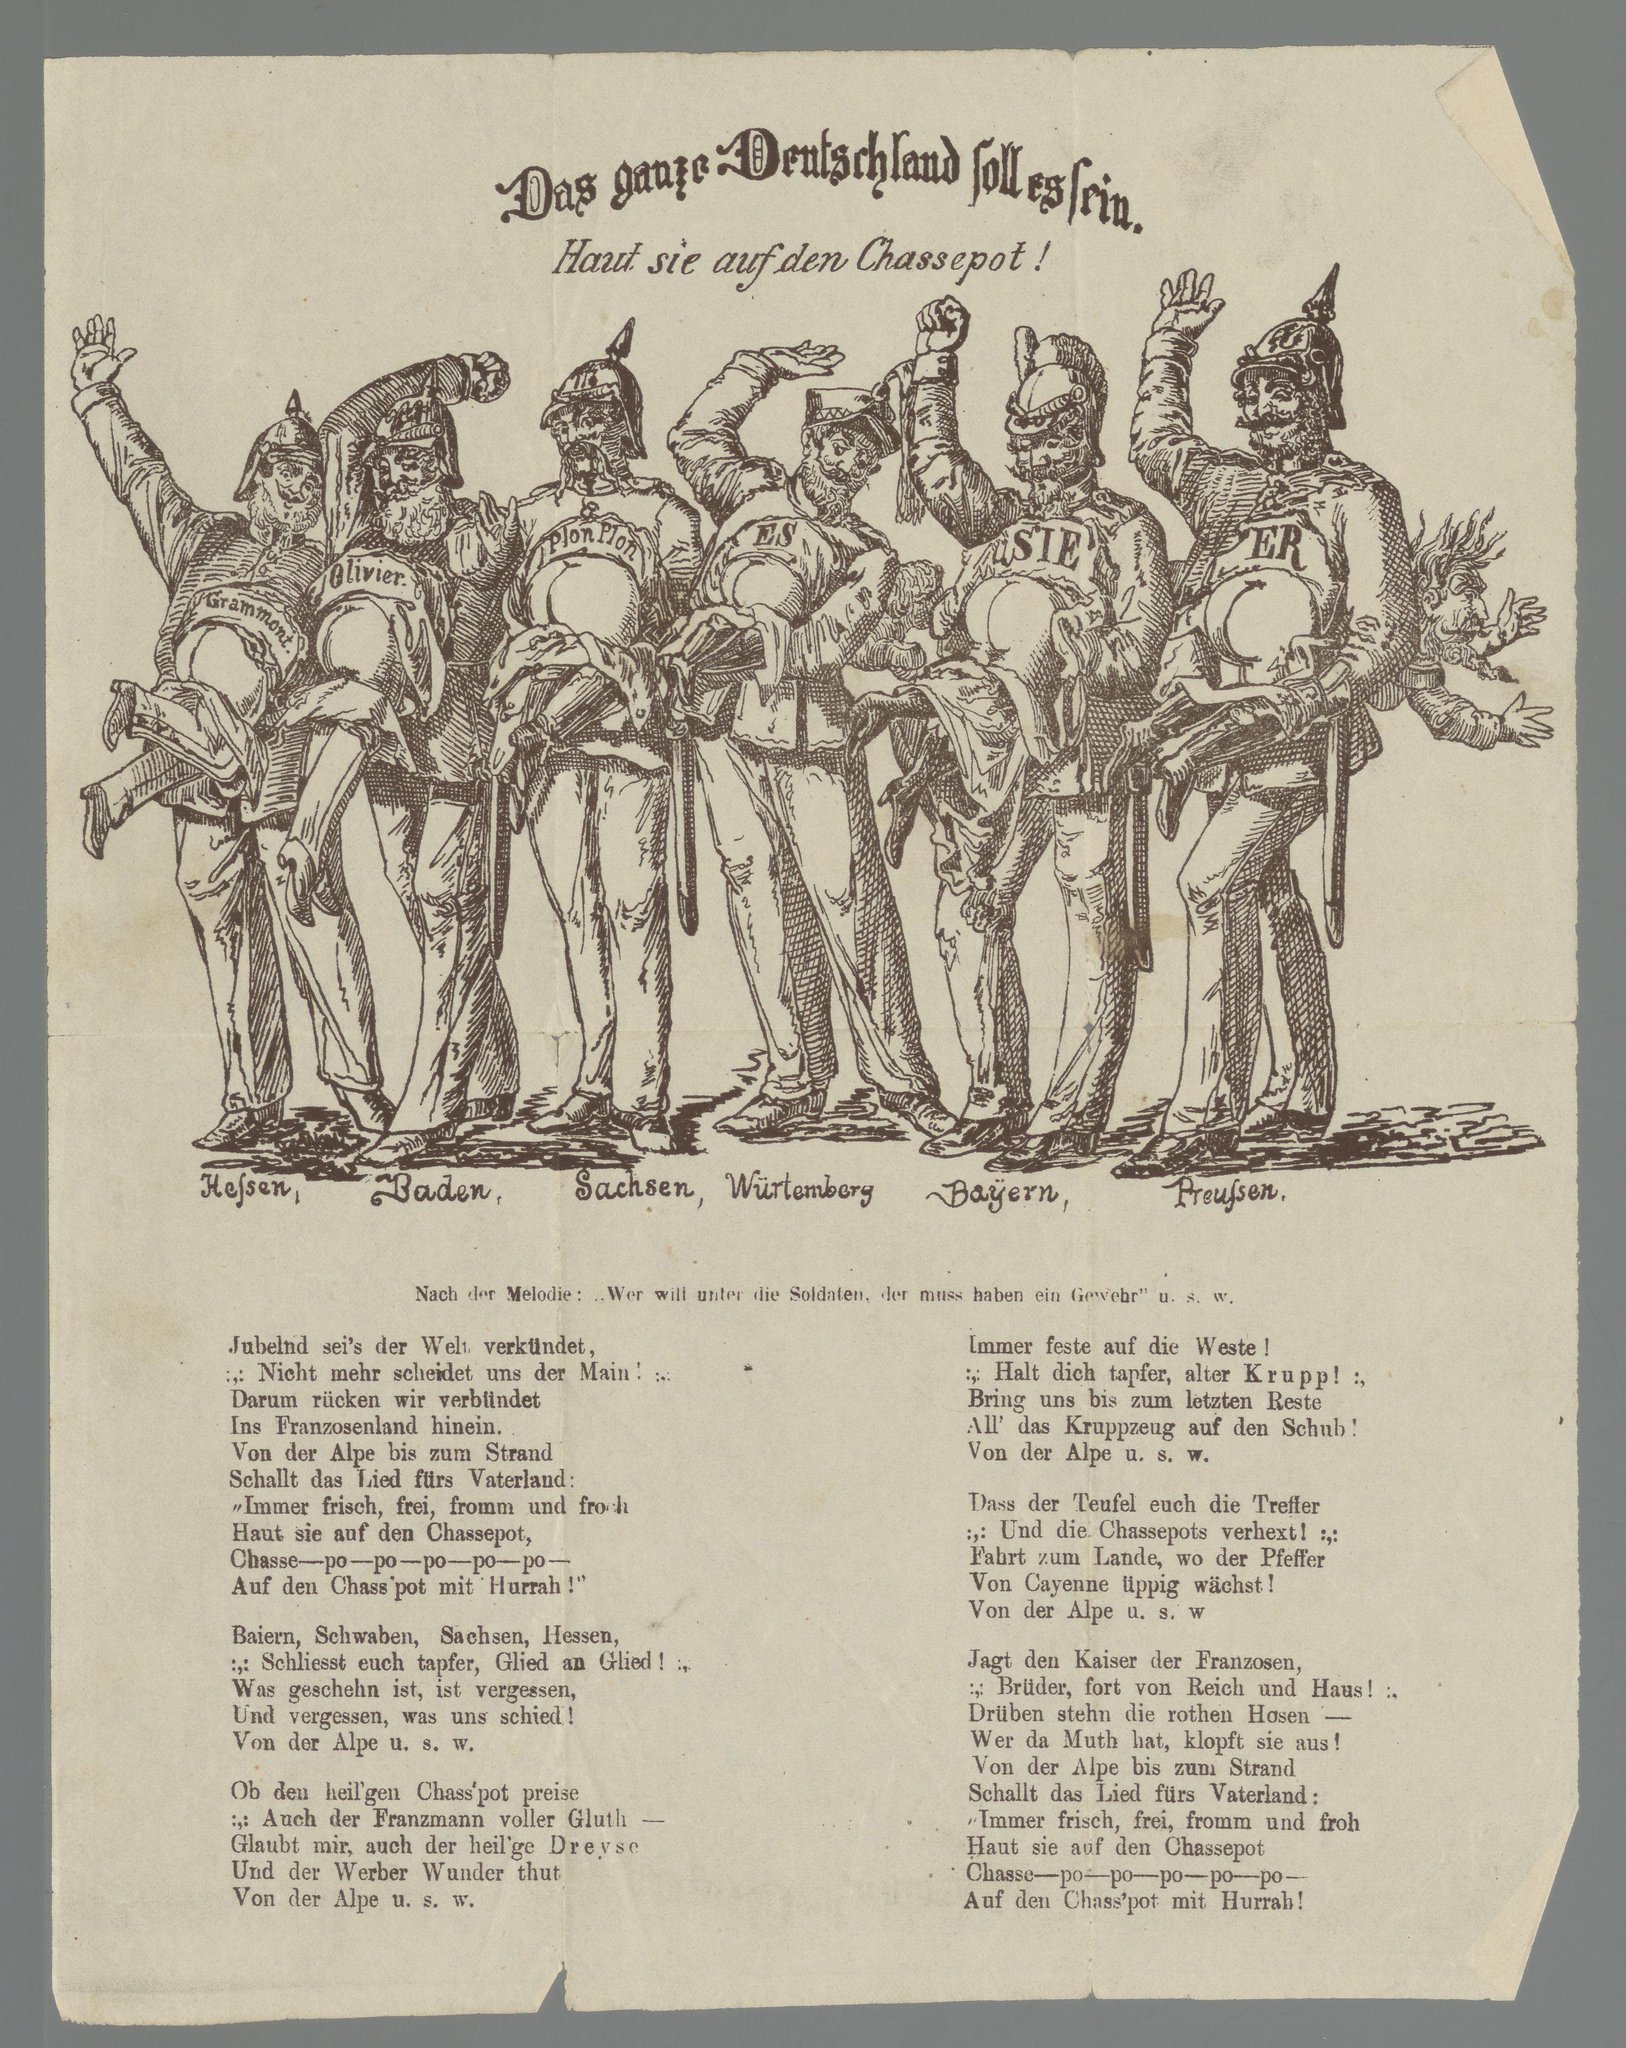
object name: print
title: Duitse staten slaan de Franse generaals op hun blote achterwerk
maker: Anonymous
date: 1870-1871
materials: paper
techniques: lithograph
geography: germany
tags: london, napoleon iii (keizer der fransen), spanking, drubbing (of naughty children)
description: Spotprent op de nederlagen van Frankrijk in de Frans-Duitse oorlog van 1870-1871. De verschillende Duitse staten slaan de Franse generaals op hun blote achterwerk, uiterst rechts keizer Napoleon III. In het onderschrift een Duits vers in zes coupletten.